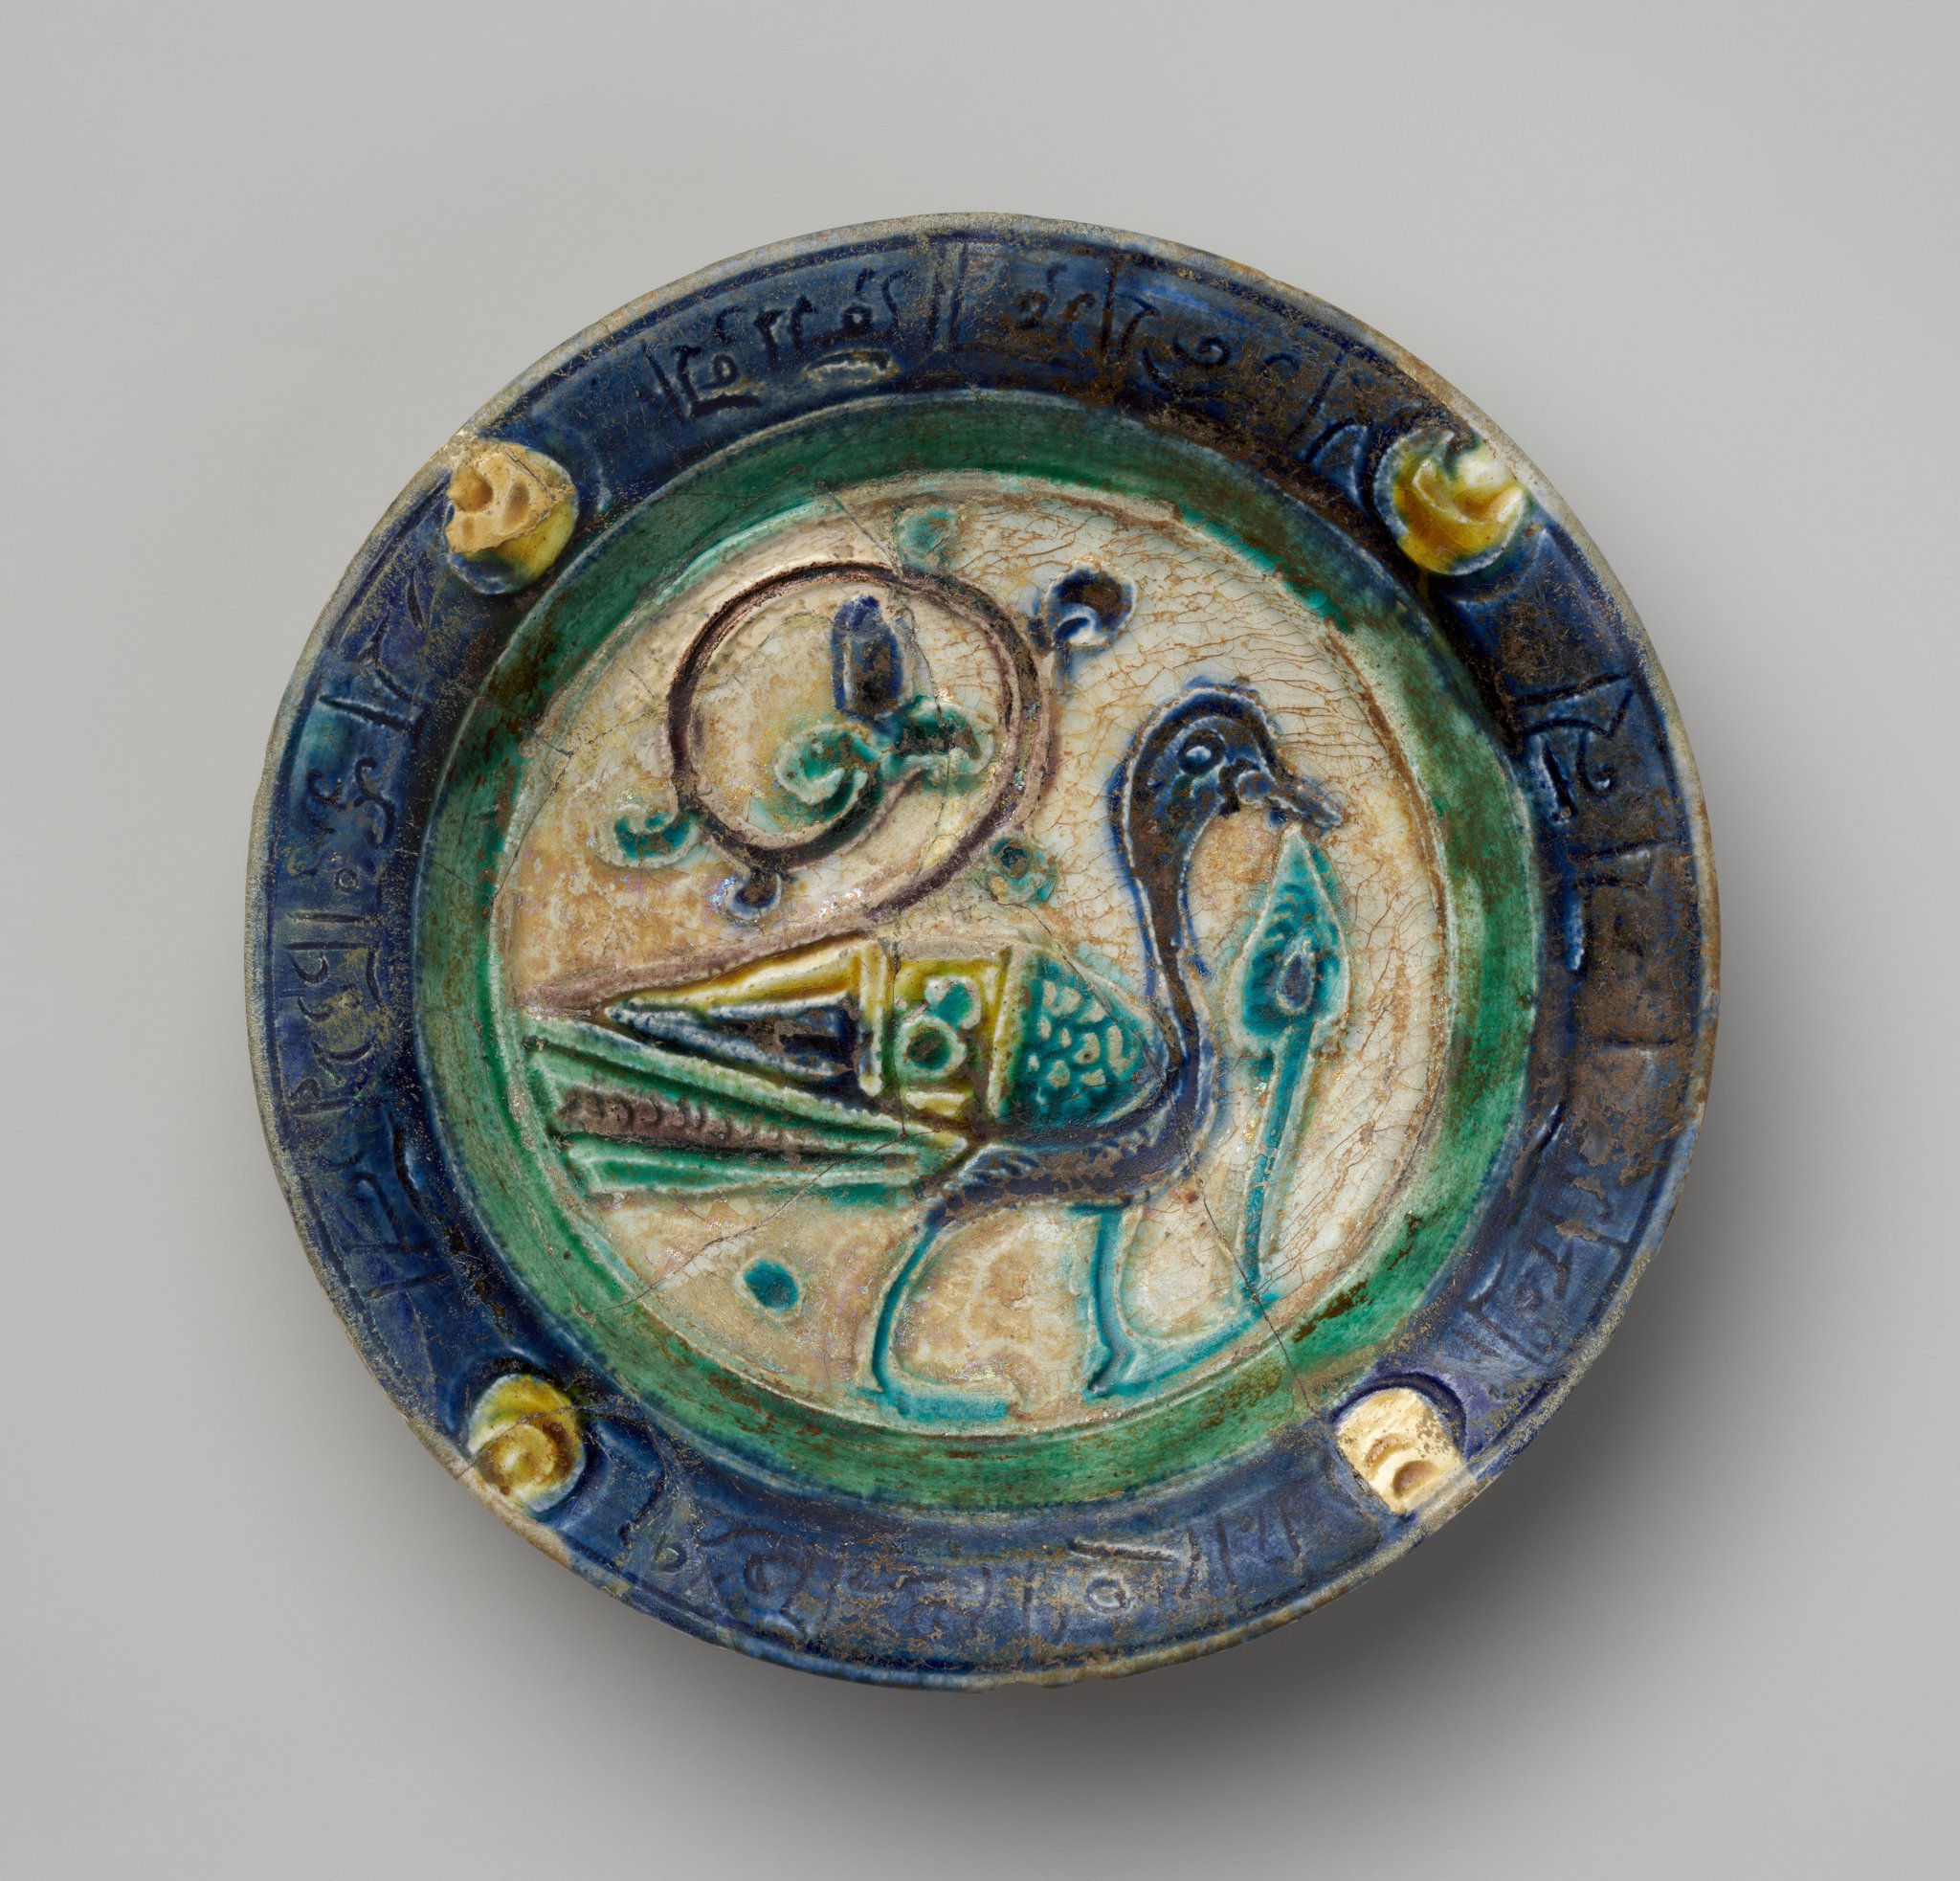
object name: dish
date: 1101-1200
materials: glaze, stonepaste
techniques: carving, incising, painting, polychrome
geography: syria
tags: birds